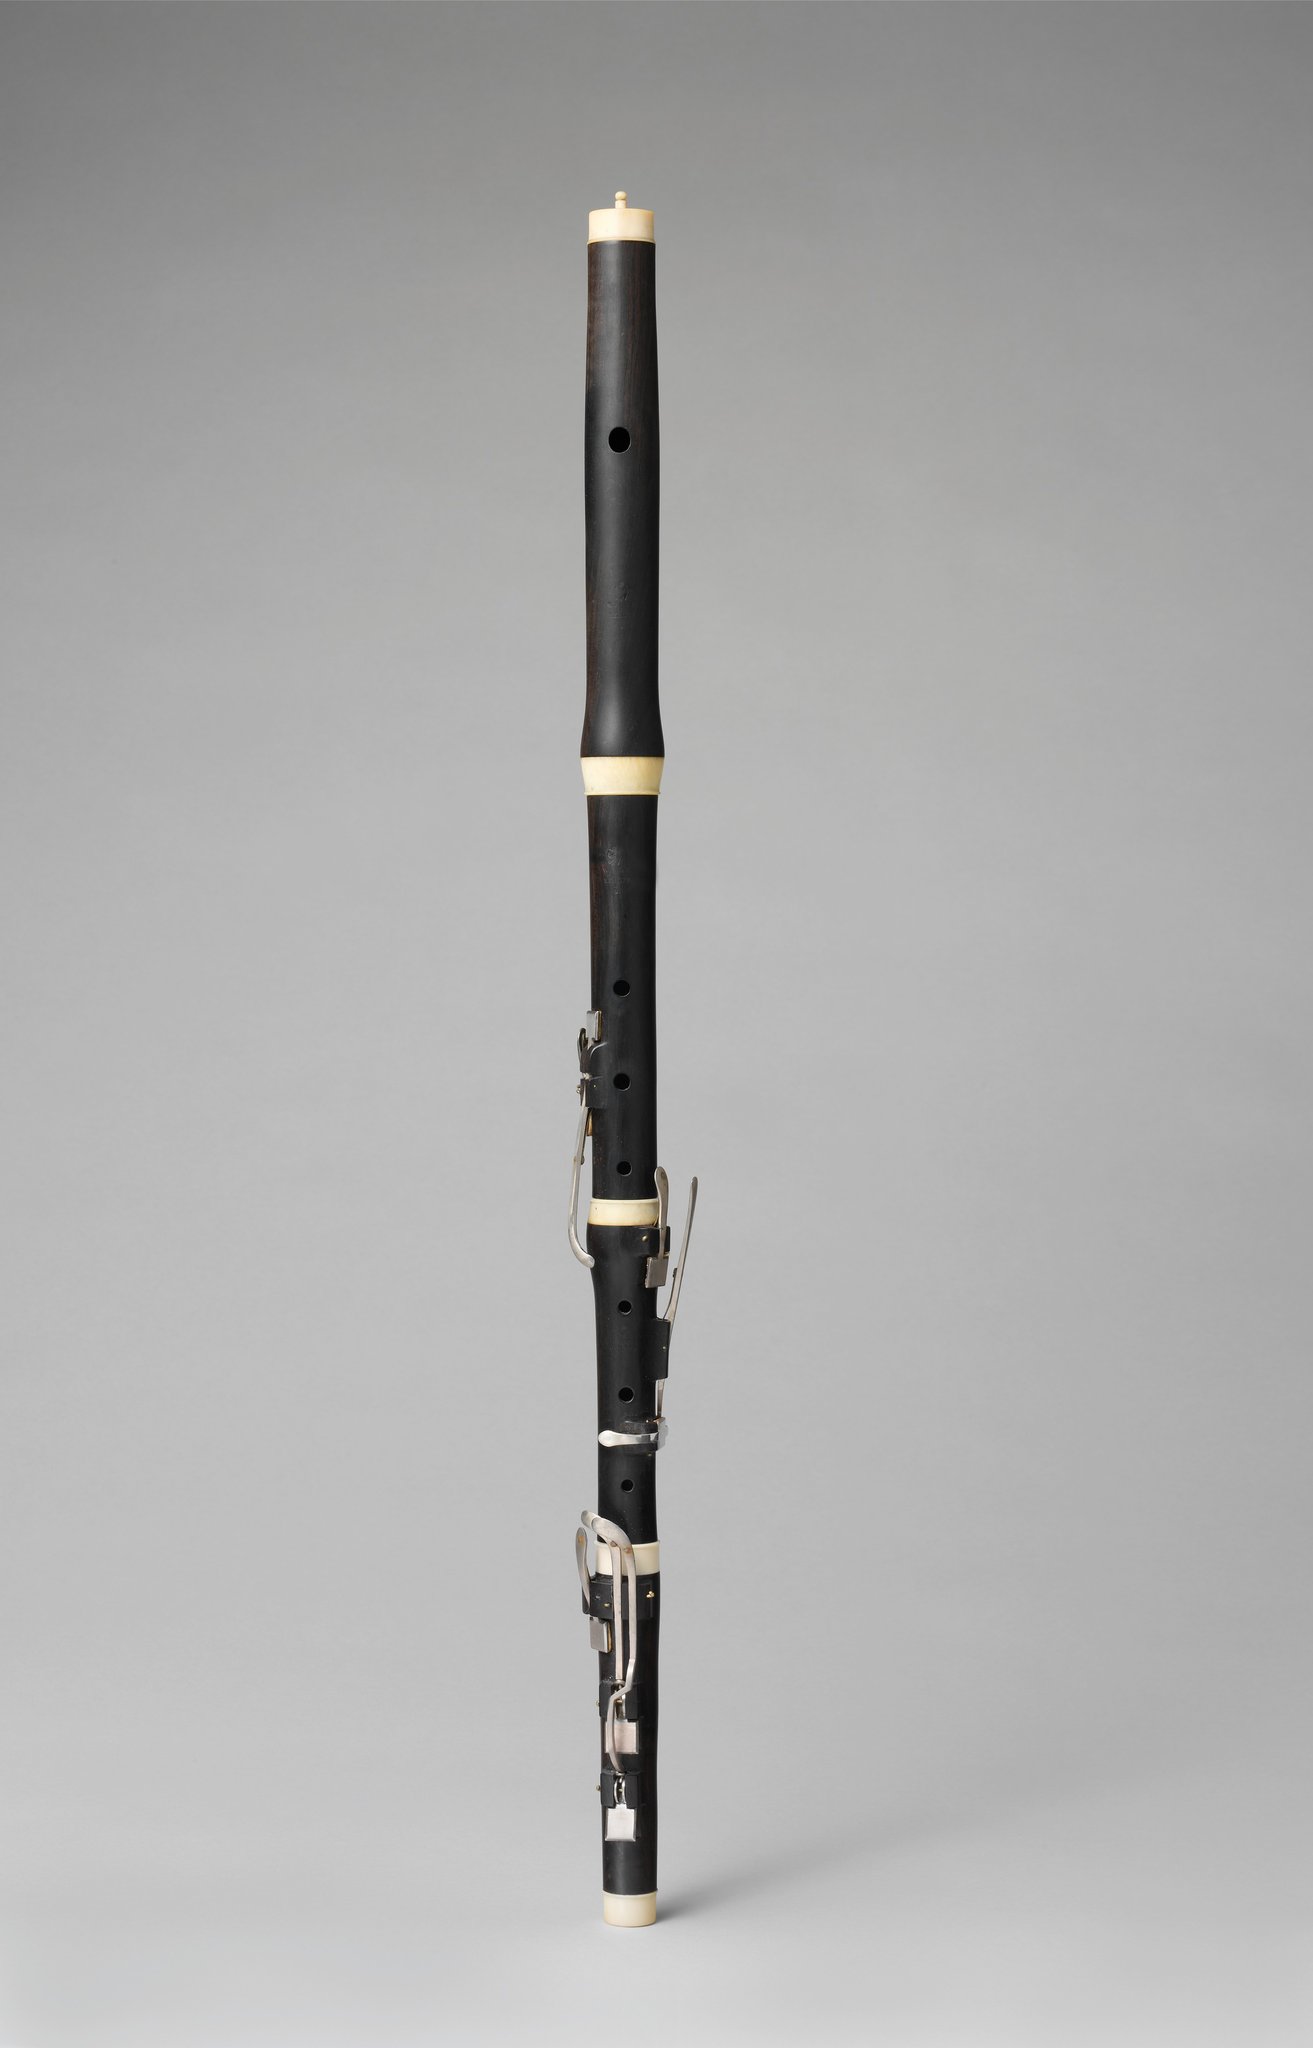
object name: transverse flute in g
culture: german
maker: johann wendelin weisse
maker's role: maker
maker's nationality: german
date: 1830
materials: ivory, silver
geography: germany